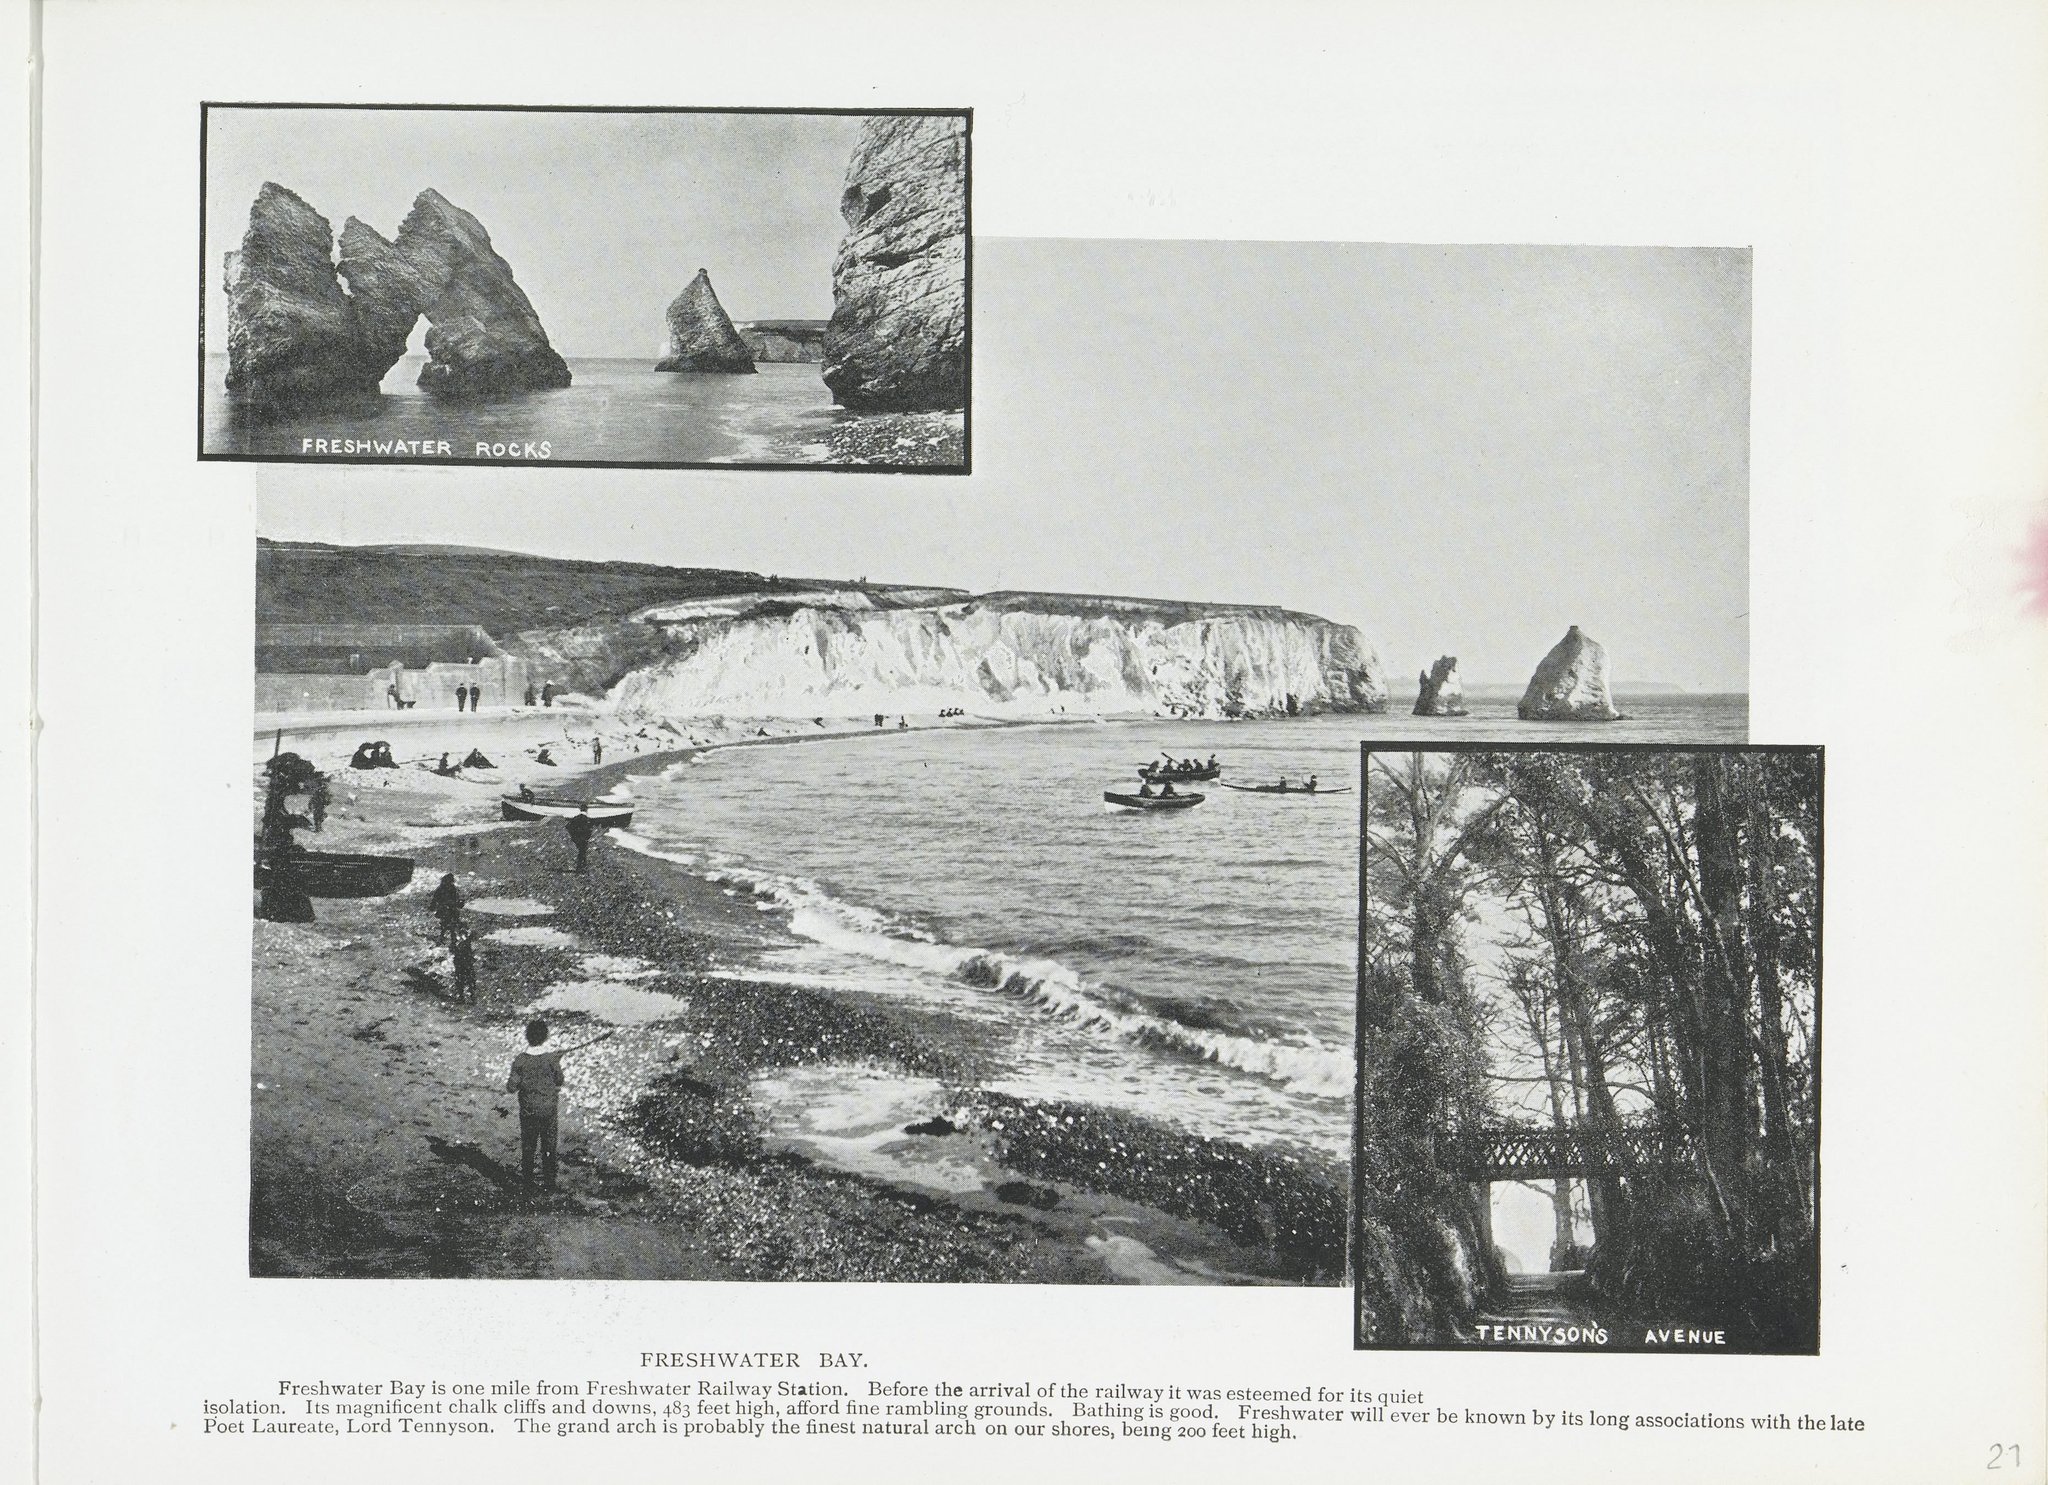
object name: page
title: Freshwater Bay, Freshwater Rocks en Tennyson's Avenue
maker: Anonymous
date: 1897-1930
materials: paper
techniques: printing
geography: isle of wight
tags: gulf, bay (+ landscape with figures, staffage), travelling; tourism, forest path or lane, bridge, coastal cliff or crag, isle of wight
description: Pagina 21 met 3 foto's van Freshwater Bay, Freshwater Rocks en Tennyson's Avenue en een bijschrift. Onderdeel van Fotografische reisreportage van het eiland Wight.